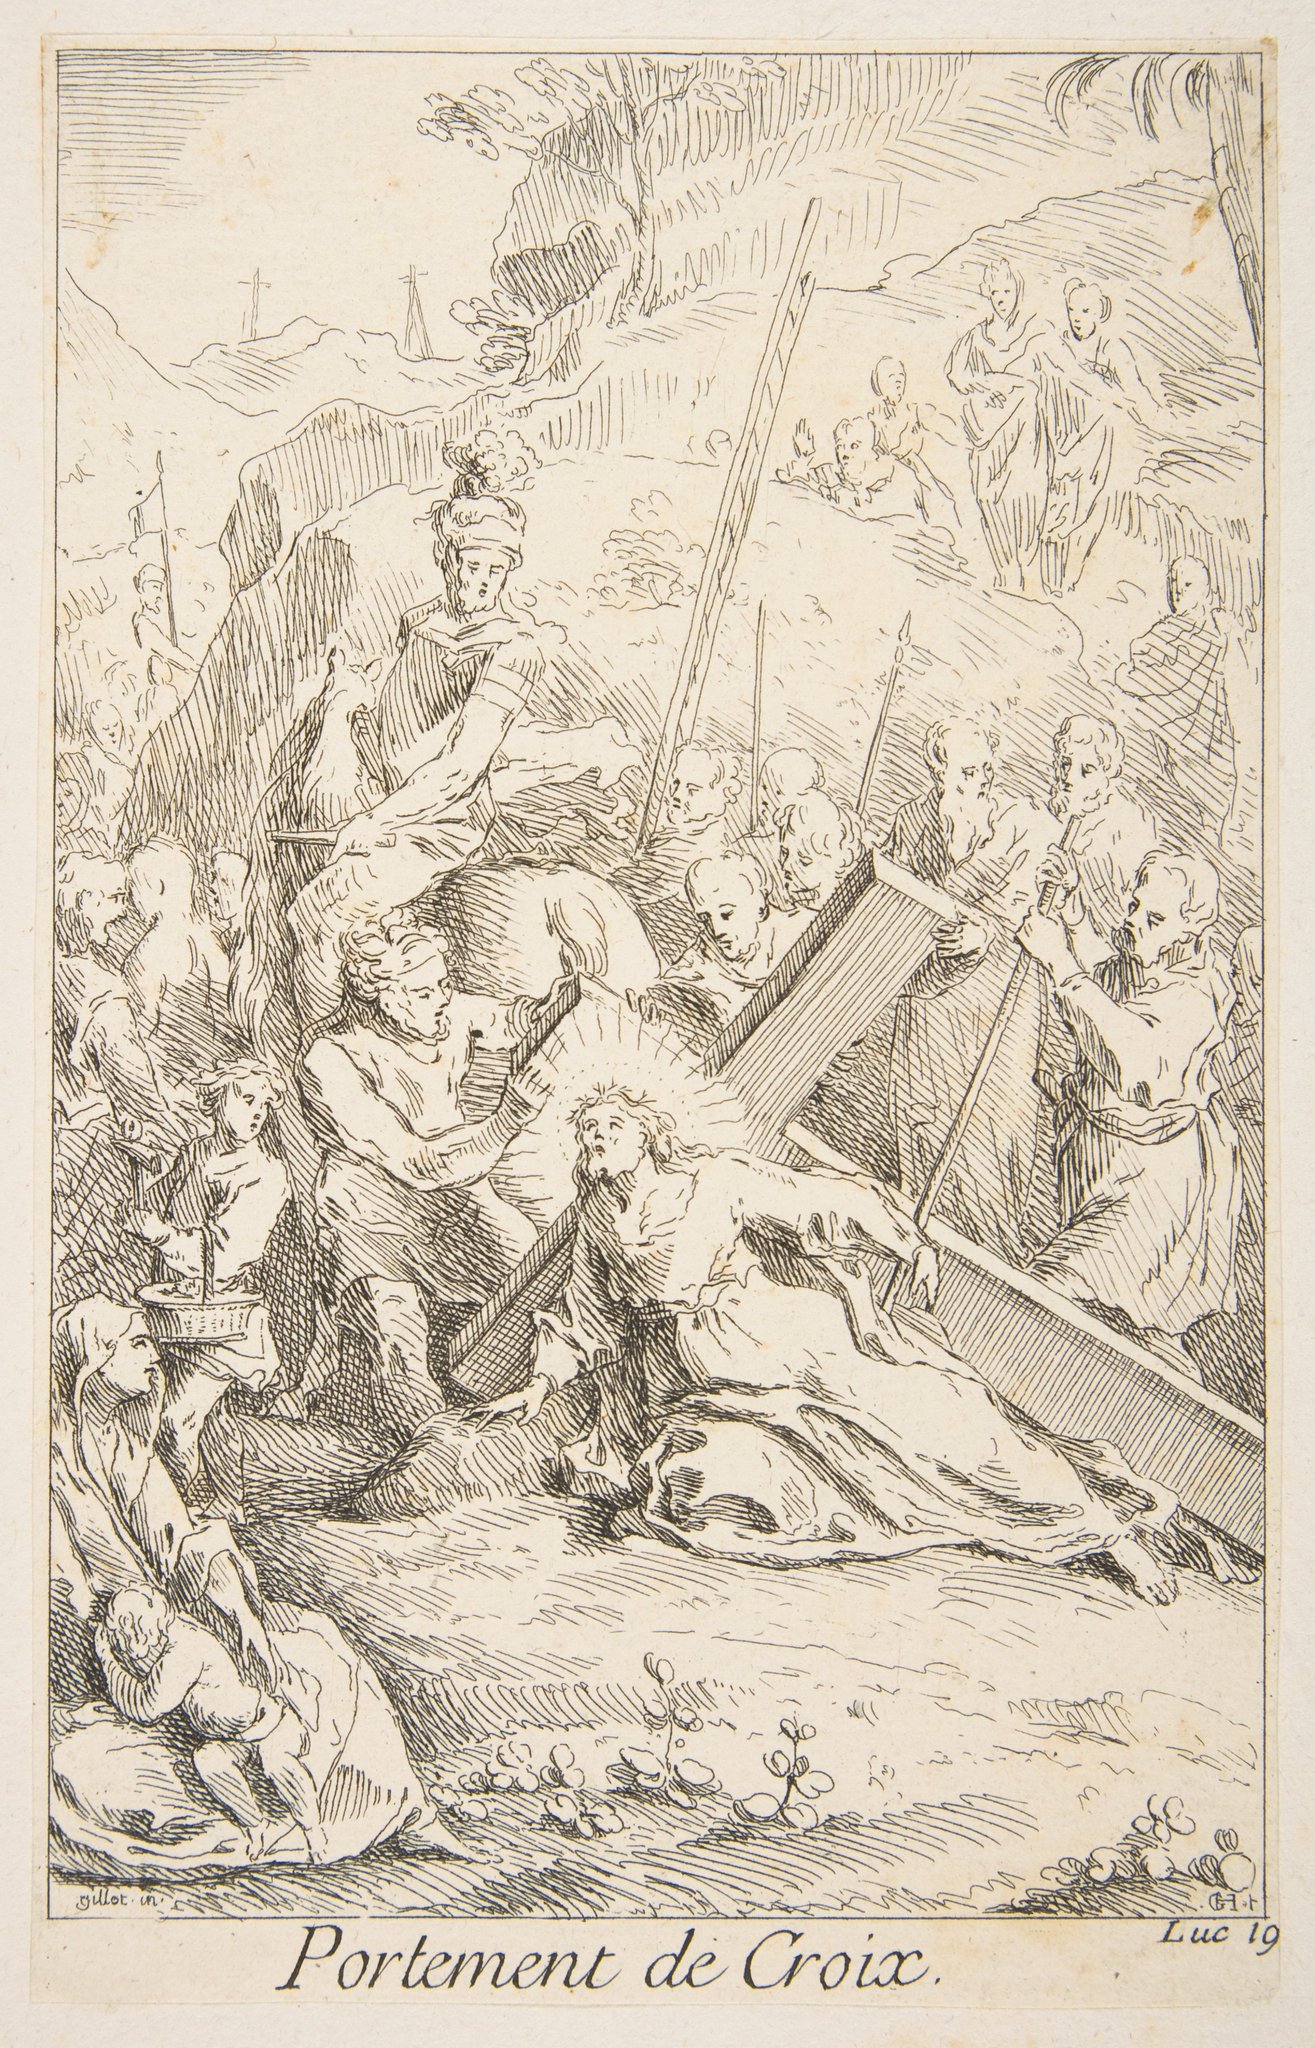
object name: print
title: Carrying the Cross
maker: claude gillot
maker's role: artist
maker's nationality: french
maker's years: 1673-1722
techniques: etching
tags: soldiers,men,christ,cross,crucifixion